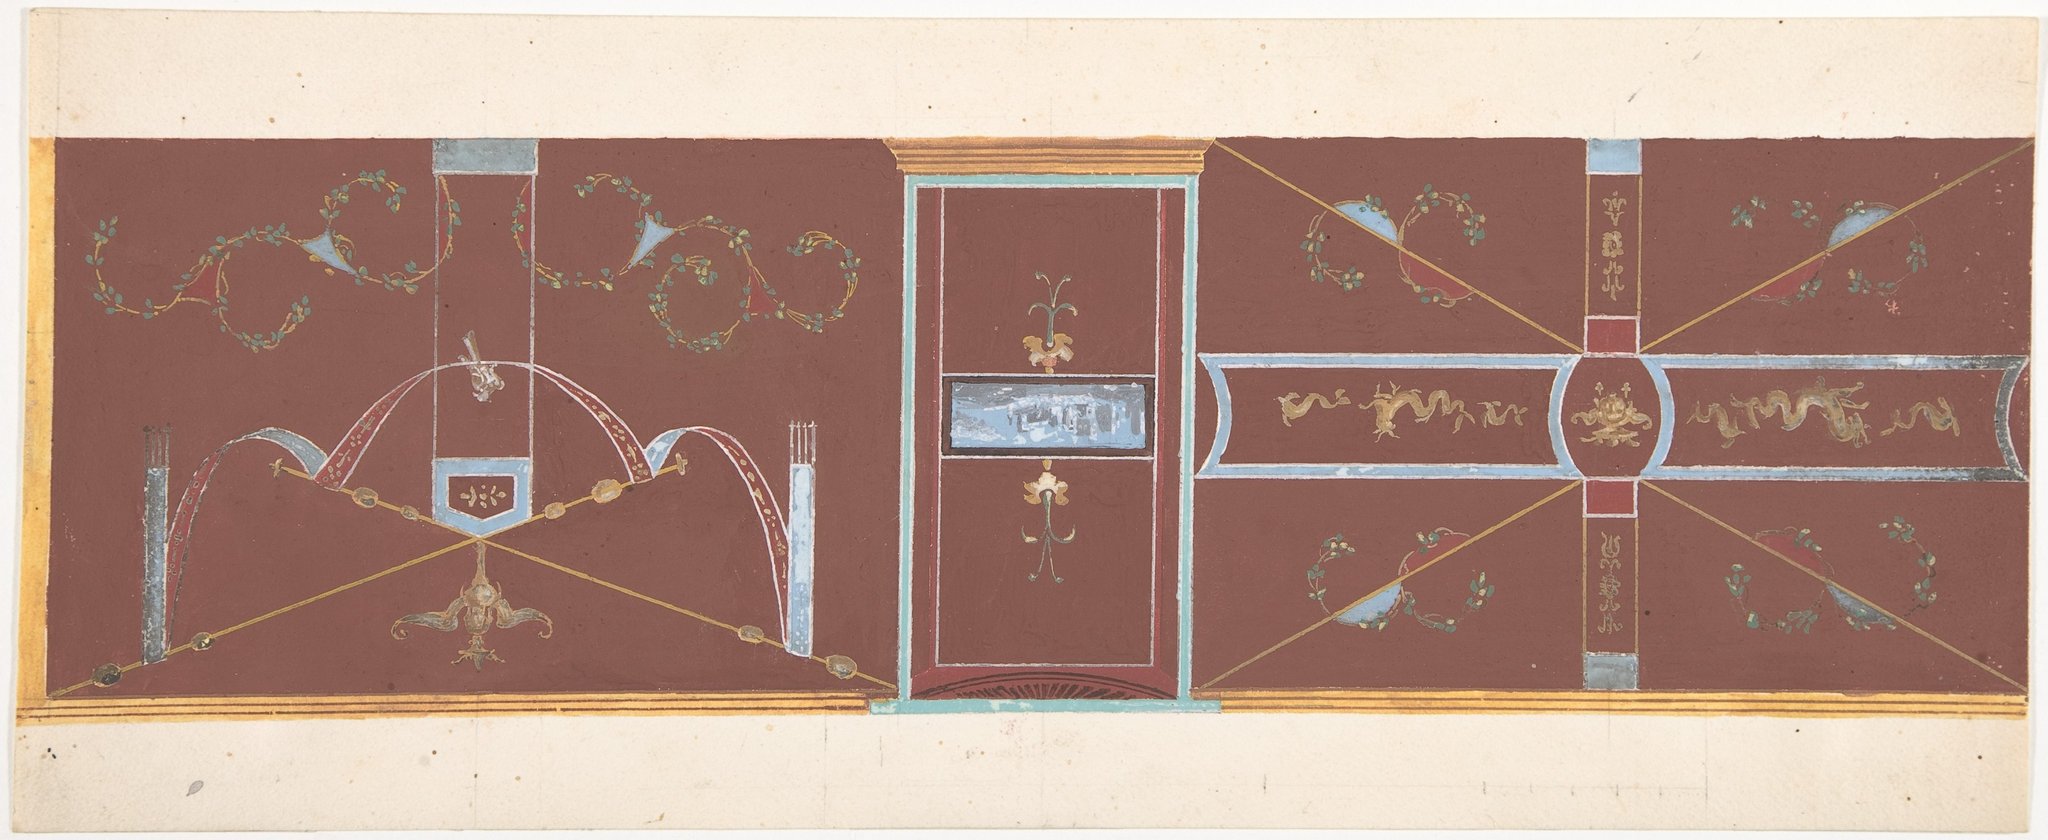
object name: drawing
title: Design for Wall Decoration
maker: pierre françois léonard fontaine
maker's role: artist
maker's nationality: french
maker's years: 1762-1853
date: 1762-1853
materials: gouache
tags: ornament